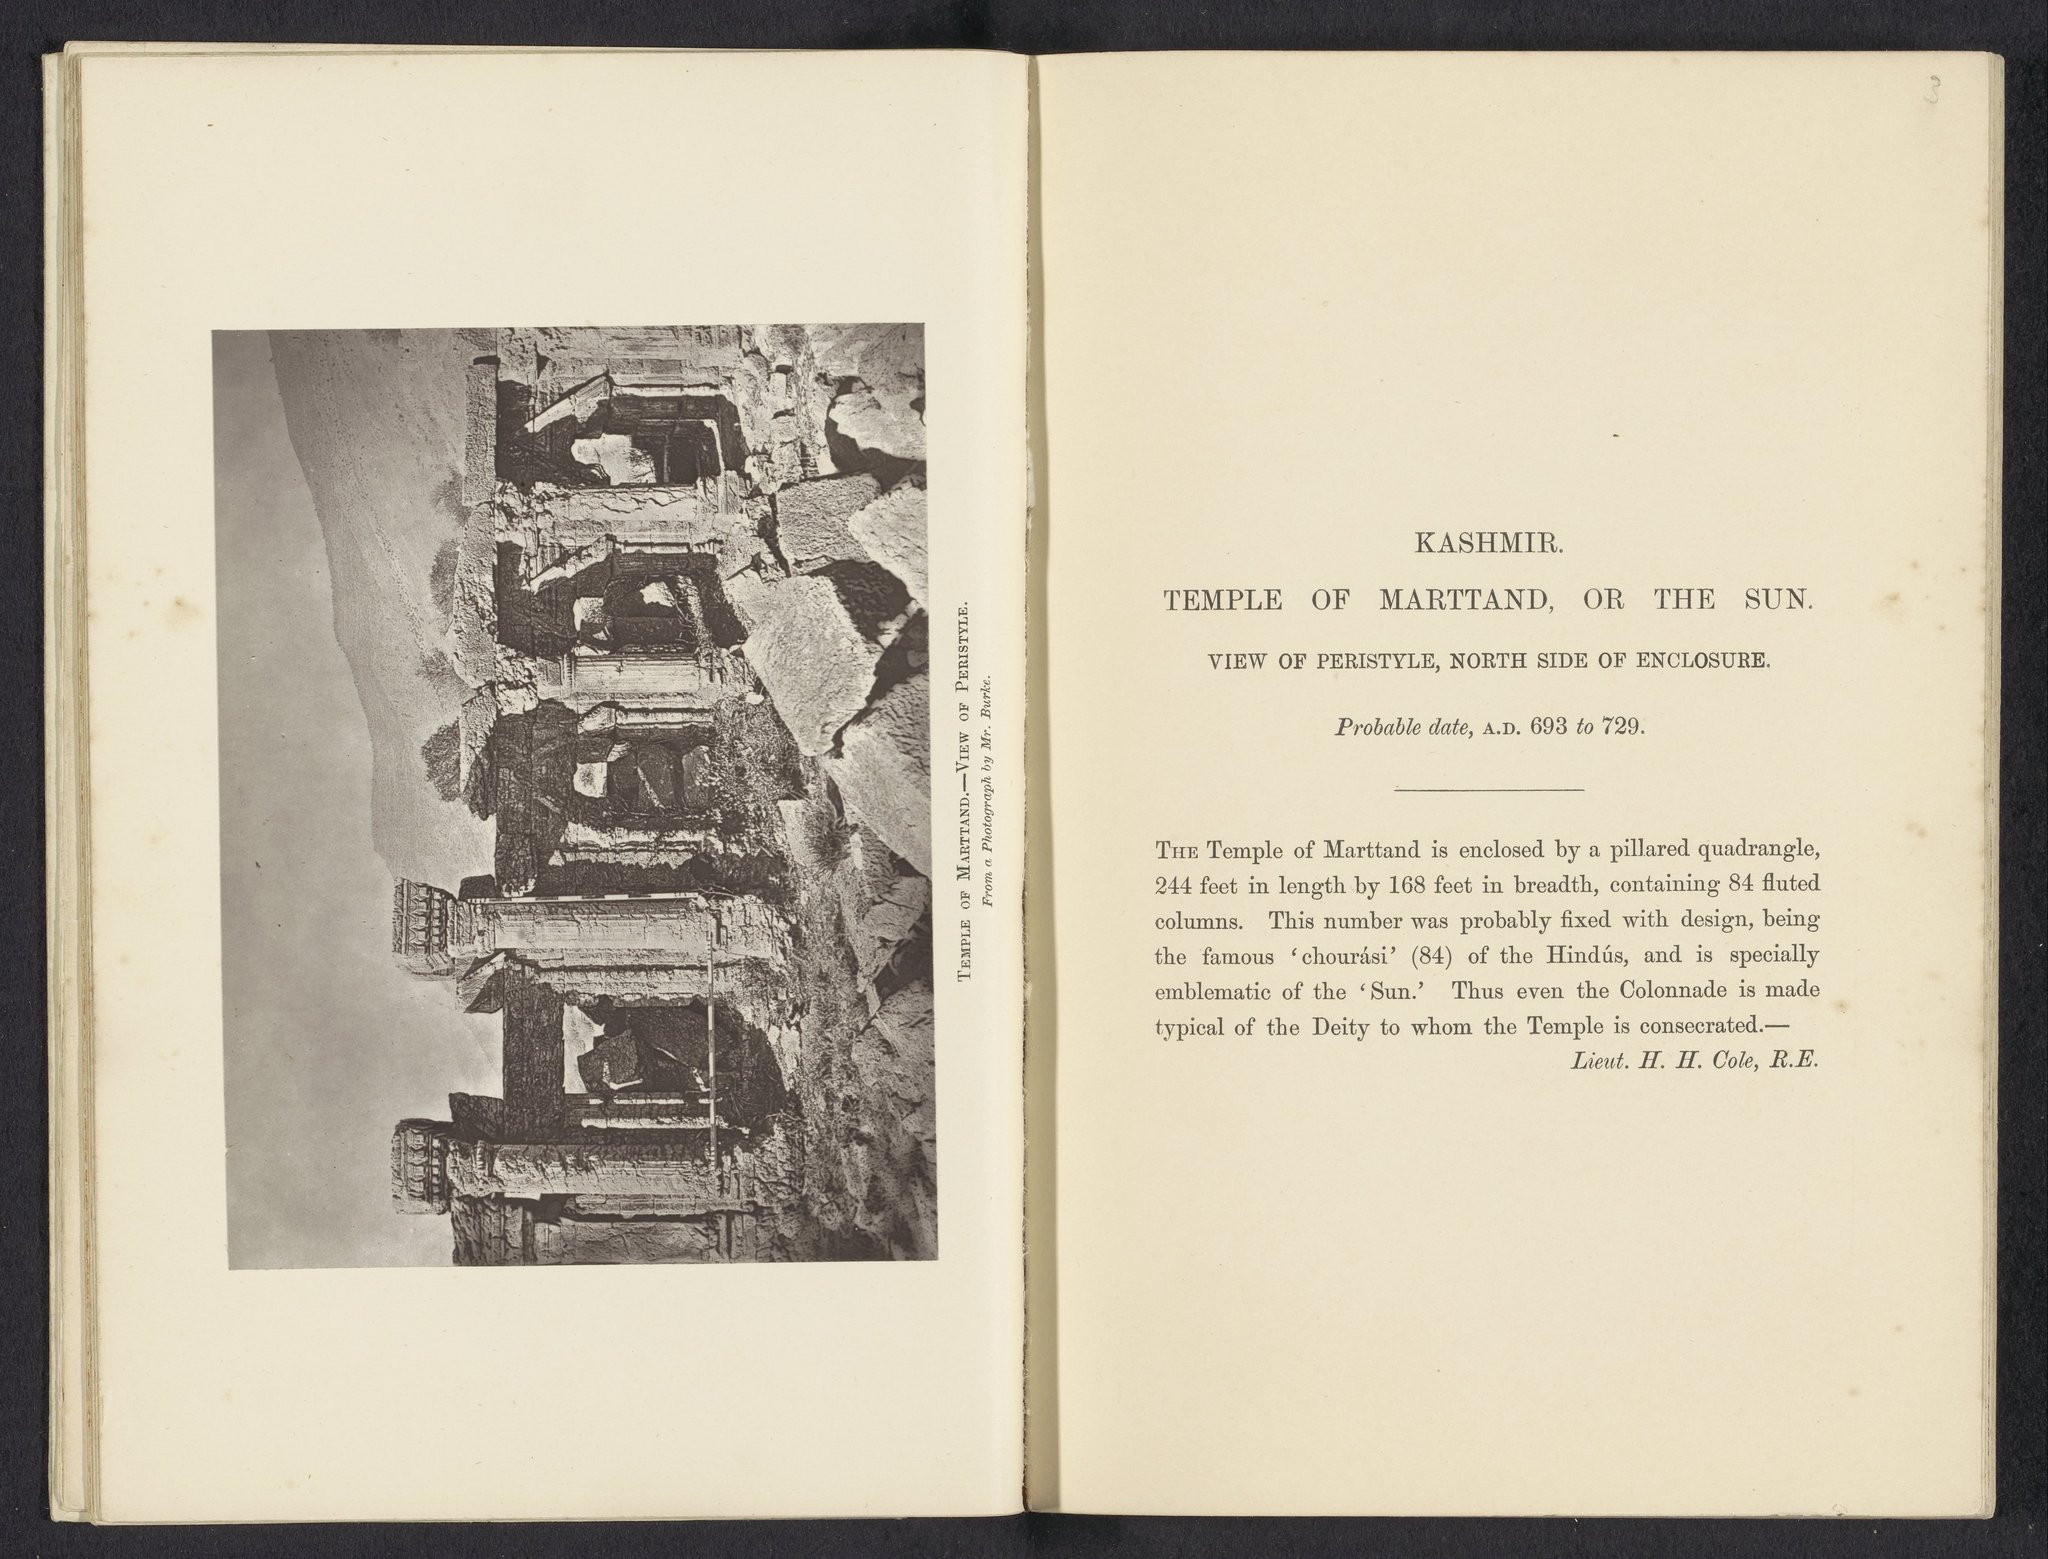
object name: photomechanical print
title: View of the peristyle of the Martand Sun Temple near Anantnag, Jammu & Kashmir, India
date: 1864-1869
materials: paper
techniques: woodburytype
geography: jammu and kashmir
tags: temple, shrine ~ hinduism, buddhism, jainism, façade (of house or building), arcade ~ architecture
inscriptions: caption: ‘TEMPLE OF MARTTAND. - VIEW OF PERISTYLE./ From a Photograph by Mr. Burke.’